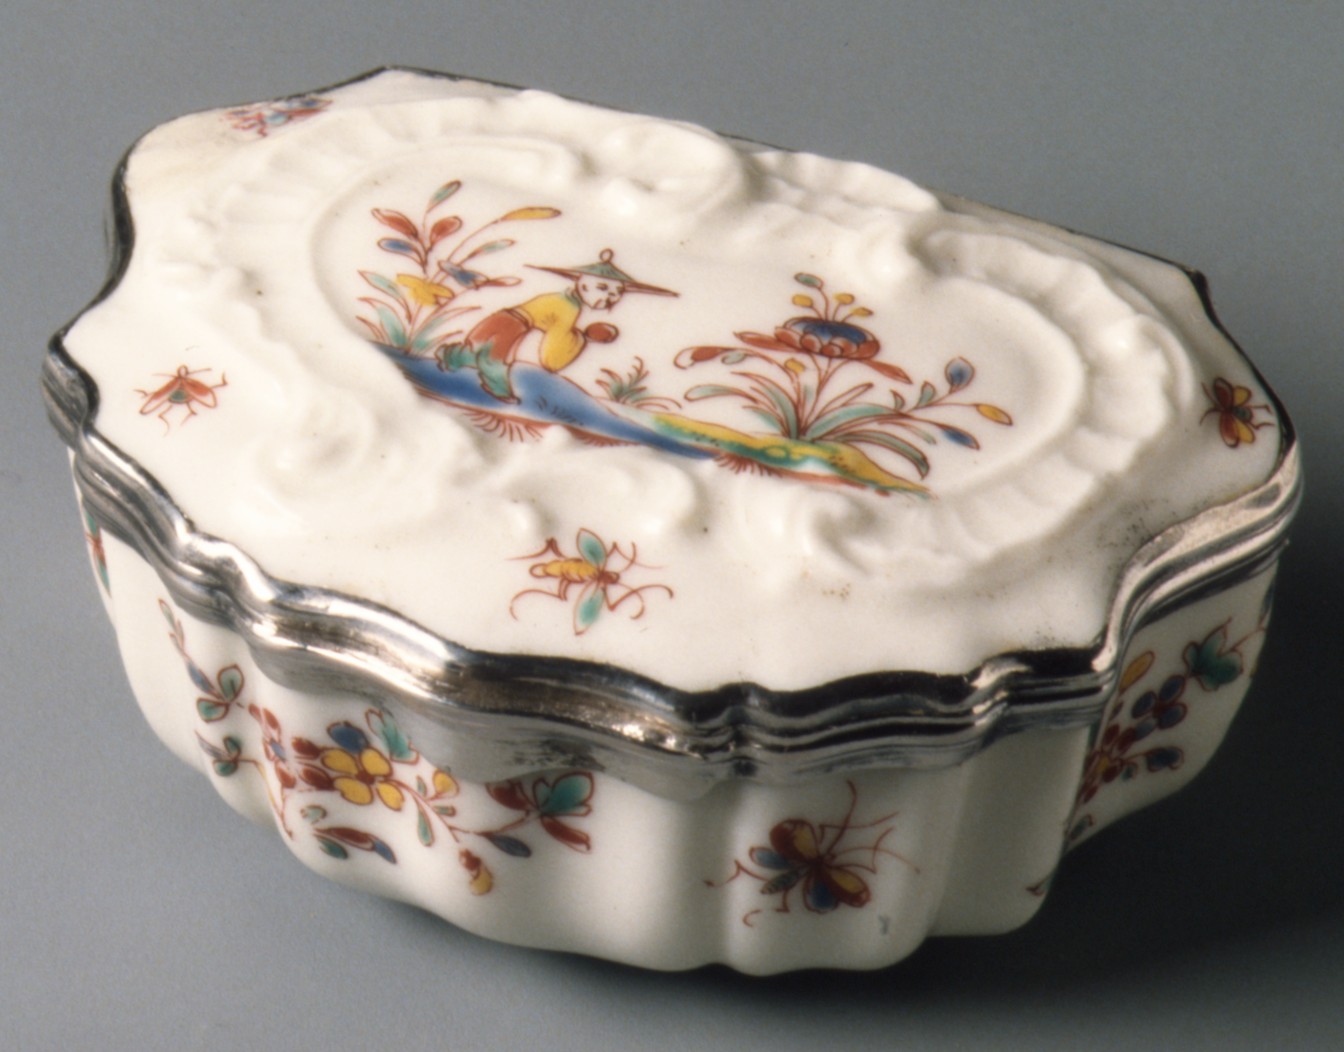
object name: snuffbox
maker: saint-cloud factory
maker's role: factory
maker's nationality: french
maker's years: 1693-1766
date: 1749-1750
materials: silver, soft paste porcelain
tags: men,insects,flowers